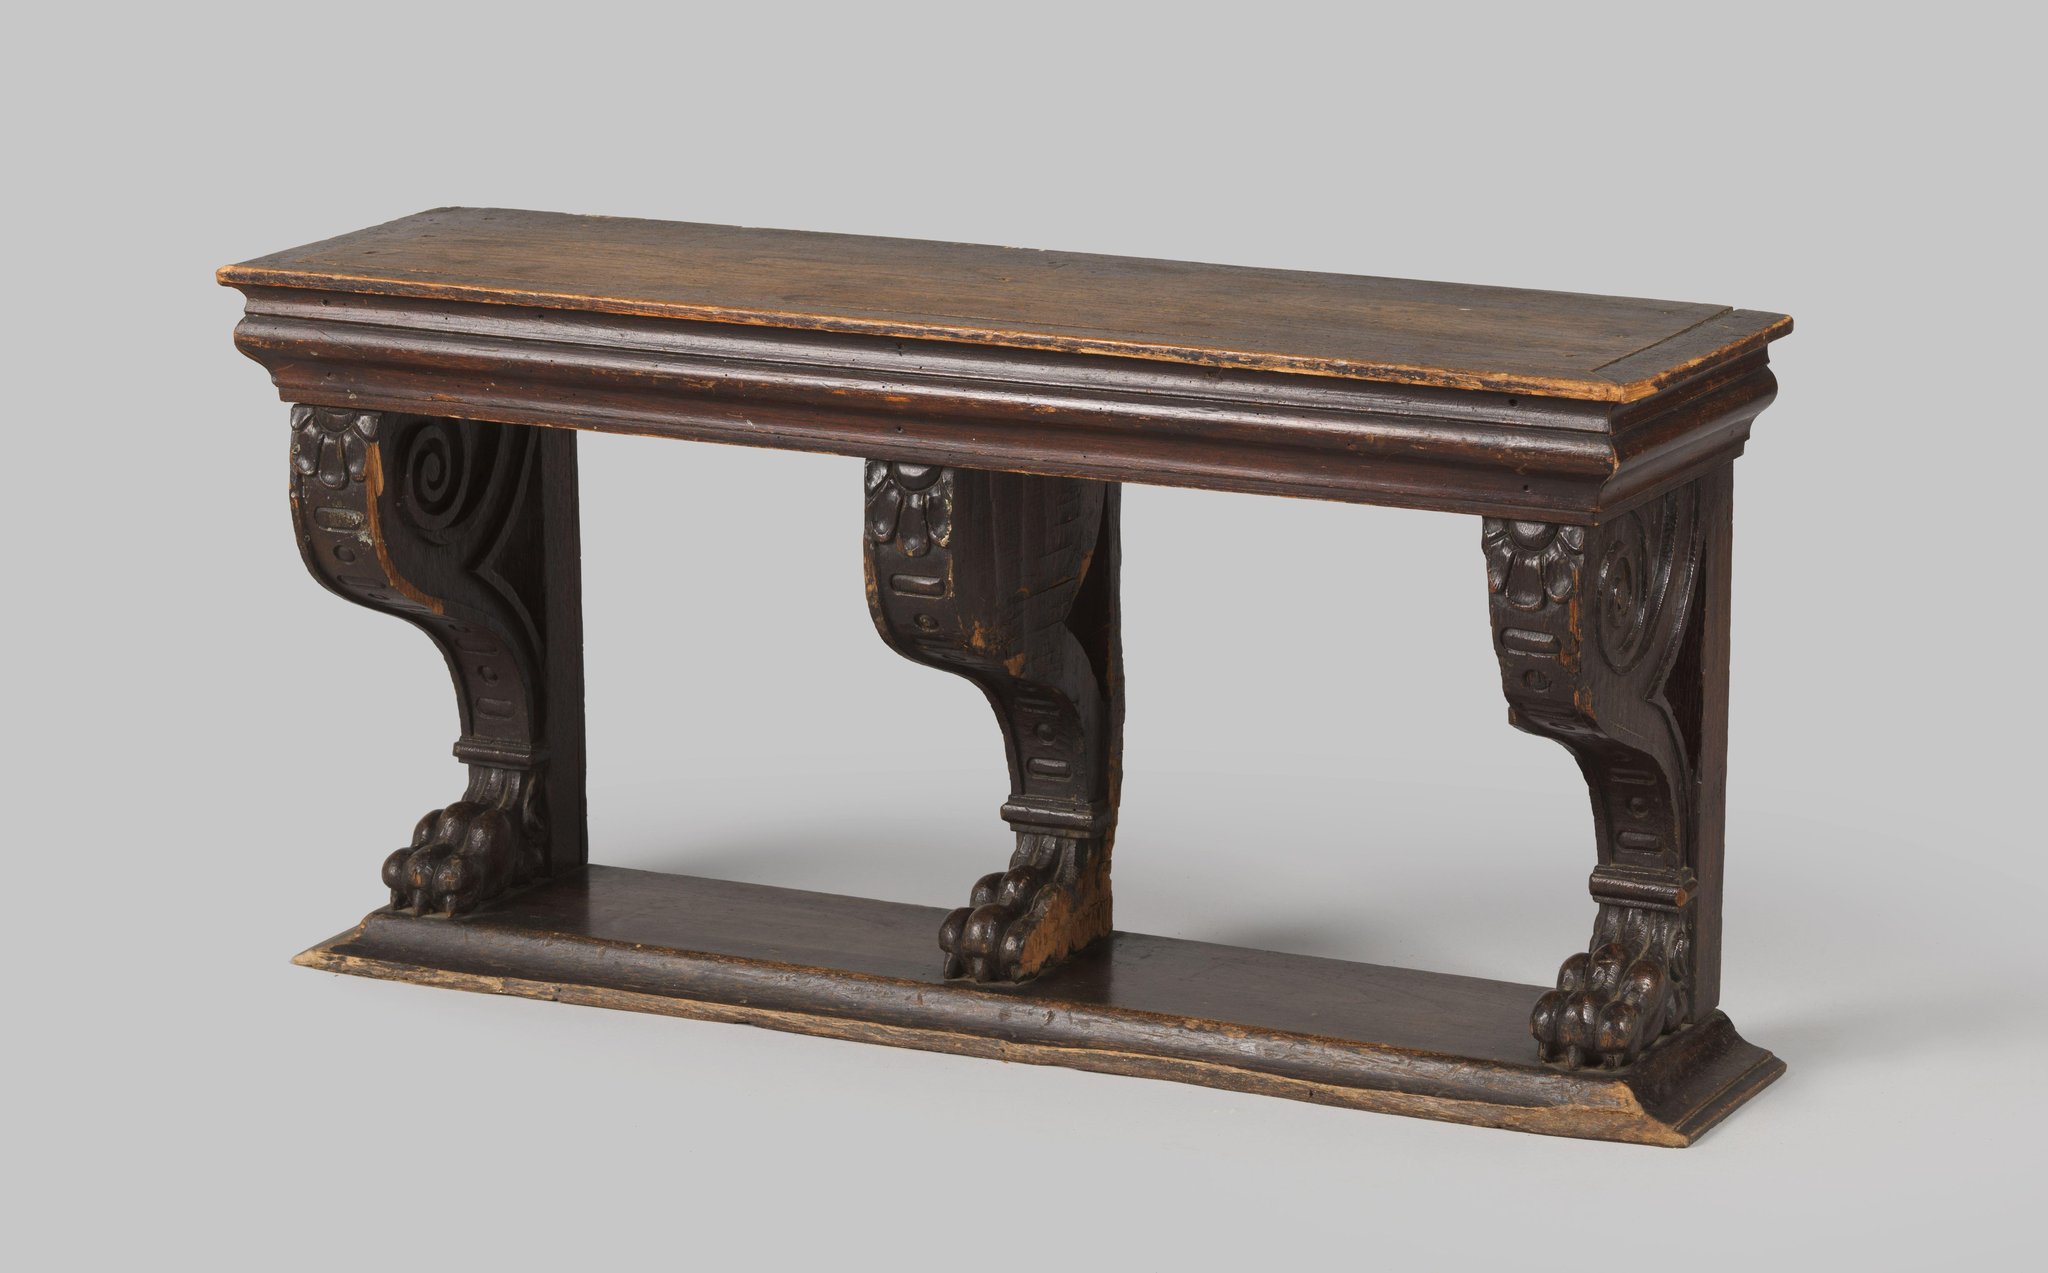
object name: furniture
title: Wandbank, rustend op drie gestoken consoles, eindigend in leeuwenklauwen.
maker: Anonymous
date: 1600-1650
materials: wood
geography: northern netherlands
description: Eikenhouten wandbank rustend op drie grof gestoken consoles, eindigend in leeuwenklauwen.